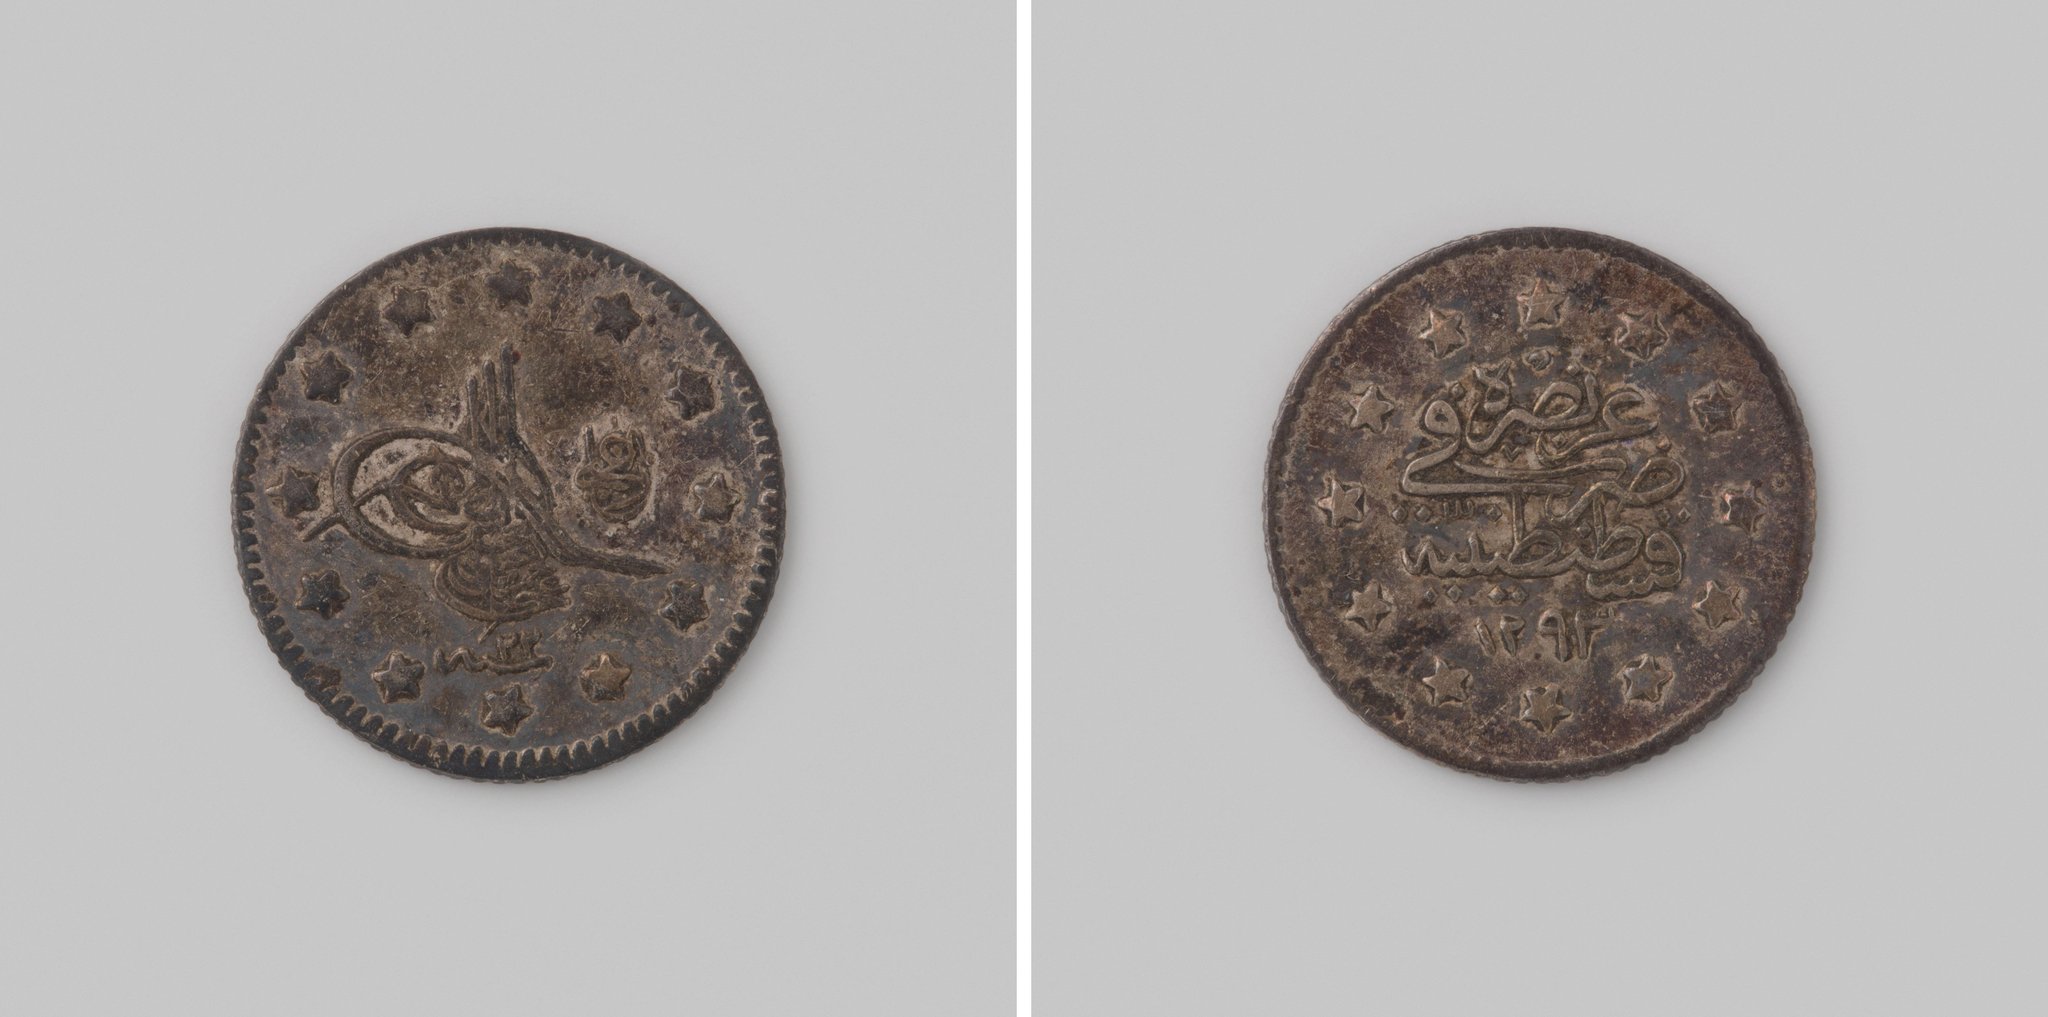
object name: coin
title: Kurush van 40 para uit Turkije van sultan Abdul Hamid, regeringsjaar 22 [=1896]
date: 1896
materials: silver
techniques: striking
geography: constantinople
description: Zilveren munt. Voorzijde: binnen twee samengebonden takken tughra met rechts daarvan aanduiding in Arabische letters: el Ghazi. Onder tughra regeringsjaar-aanduiding:4. Keerzijde: binnen binnen twee samengebonden takken drieregelig opschrift in Arabische letters met aanduiding muntplaats: Constantinopel en aanduiding jaar van aantreden: 1293 [=1875].